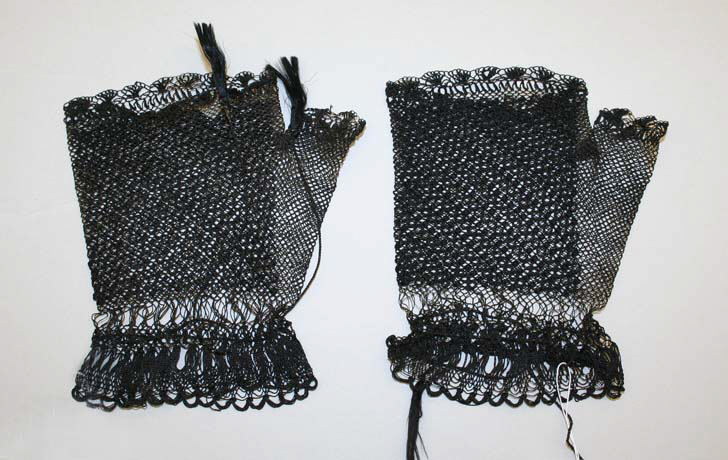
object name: mitt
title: Mitts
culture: american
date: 1801-1833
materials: silk